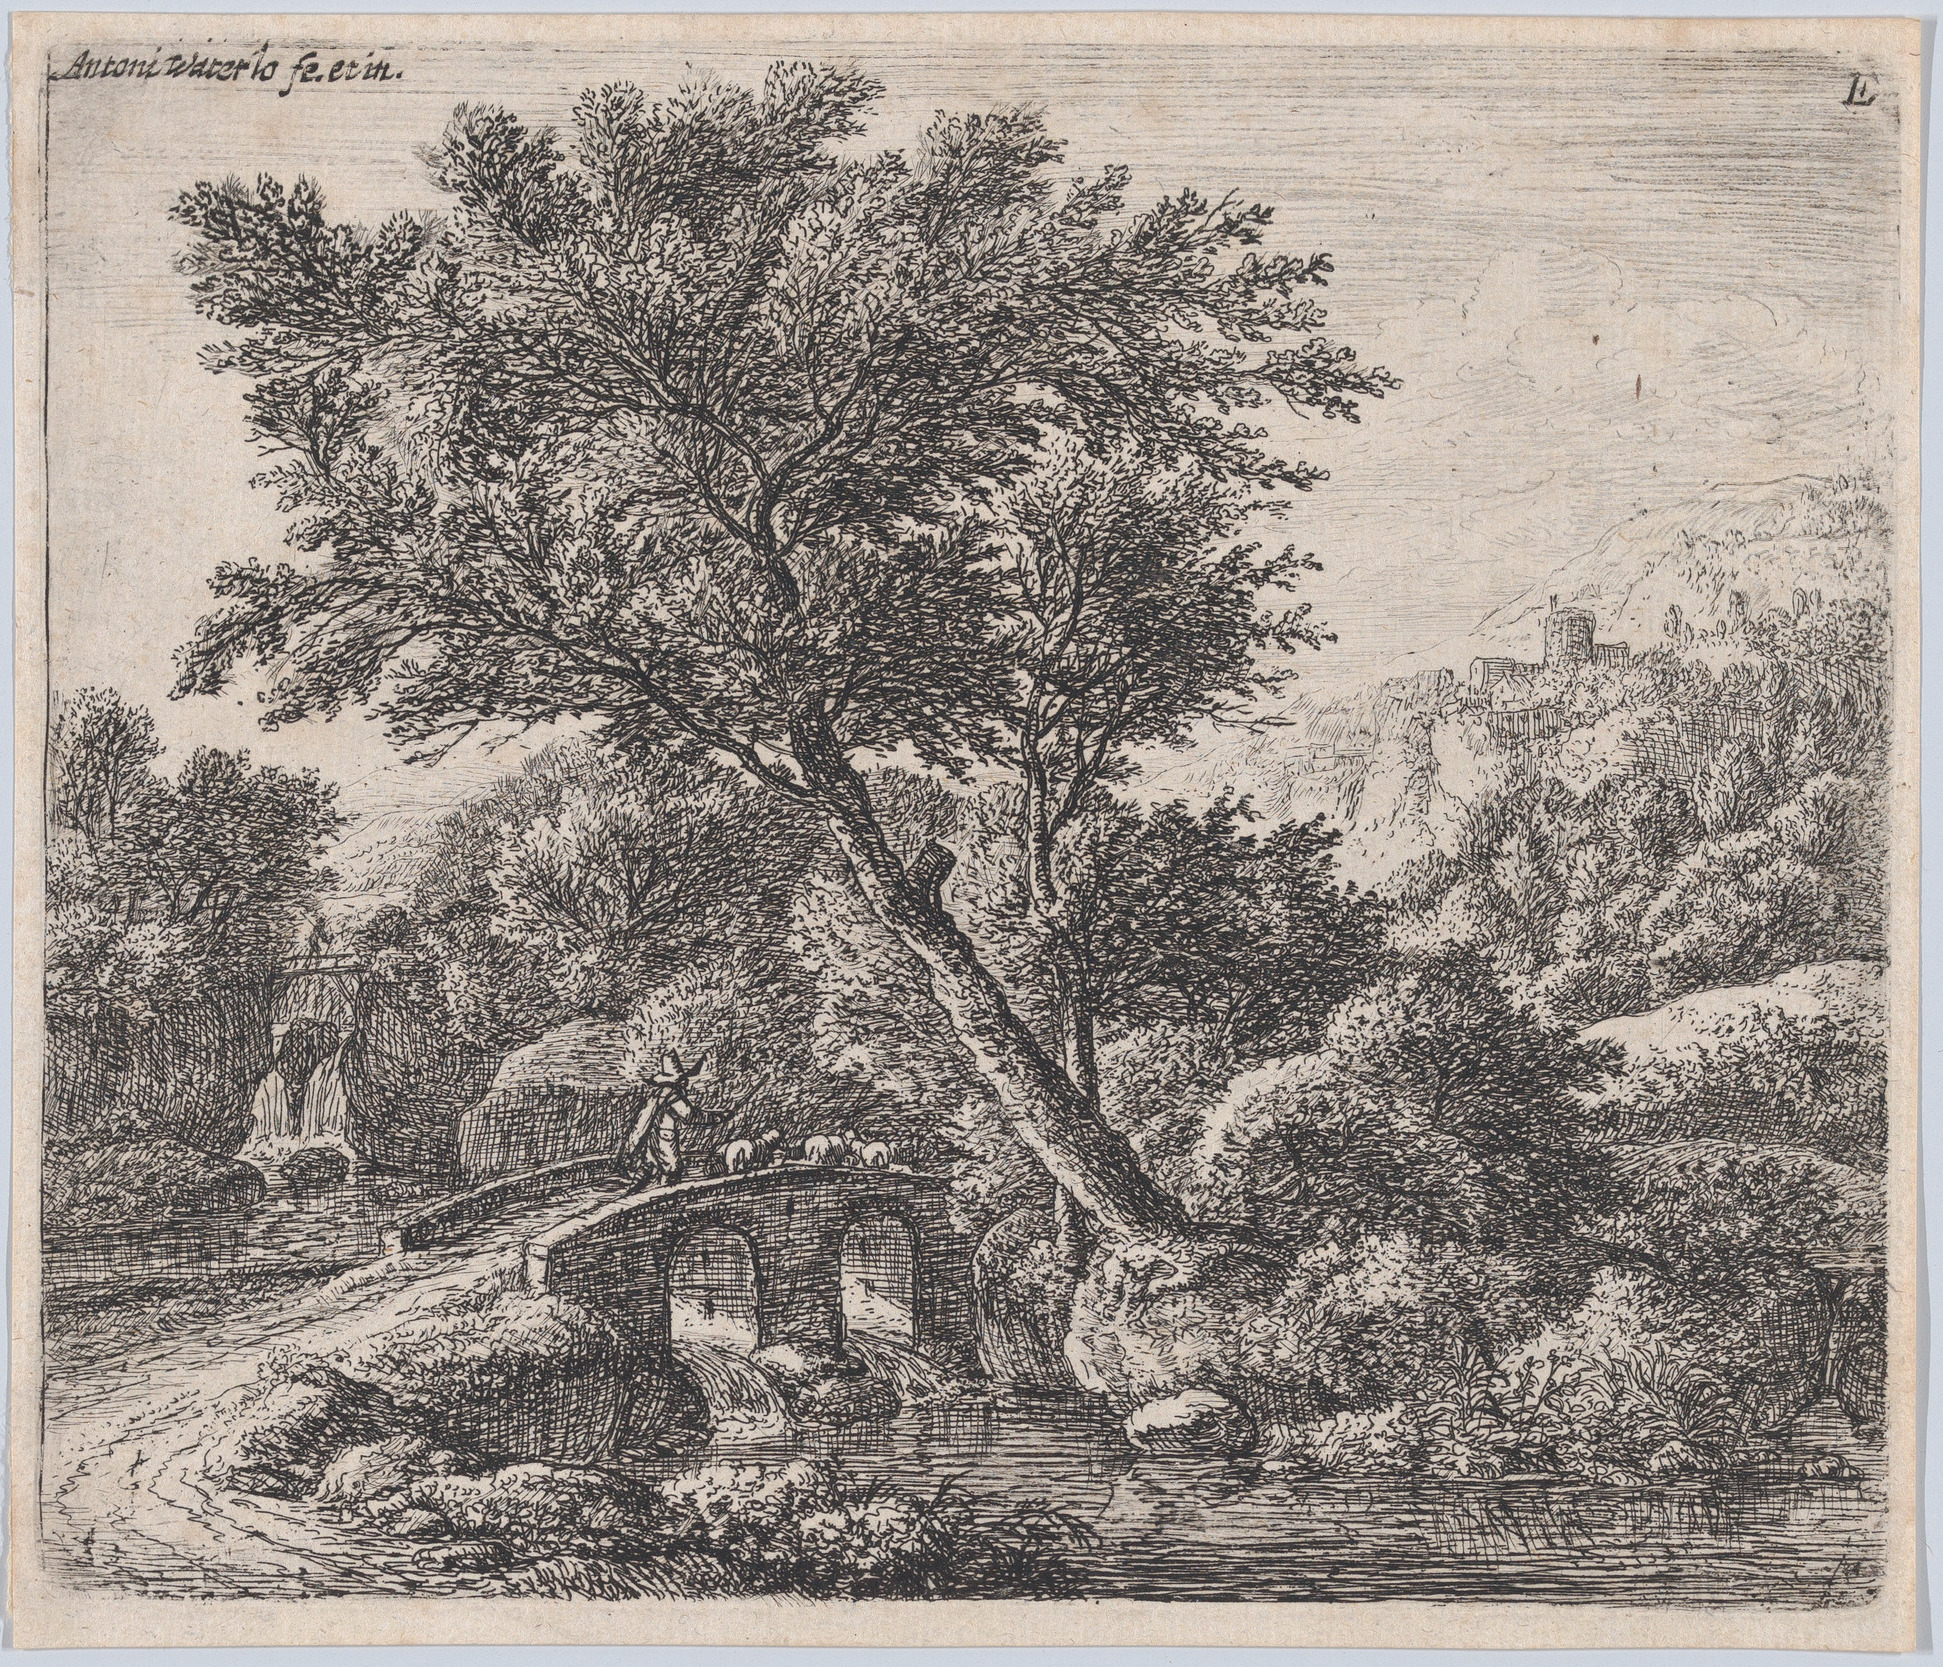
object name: print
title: Shepherd on a Small Bridge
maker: anthonie waterloo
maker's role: artist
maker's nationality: dutch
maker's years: 1609-1690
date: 1601-1700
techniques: etching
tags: bridges,trees,shepherds